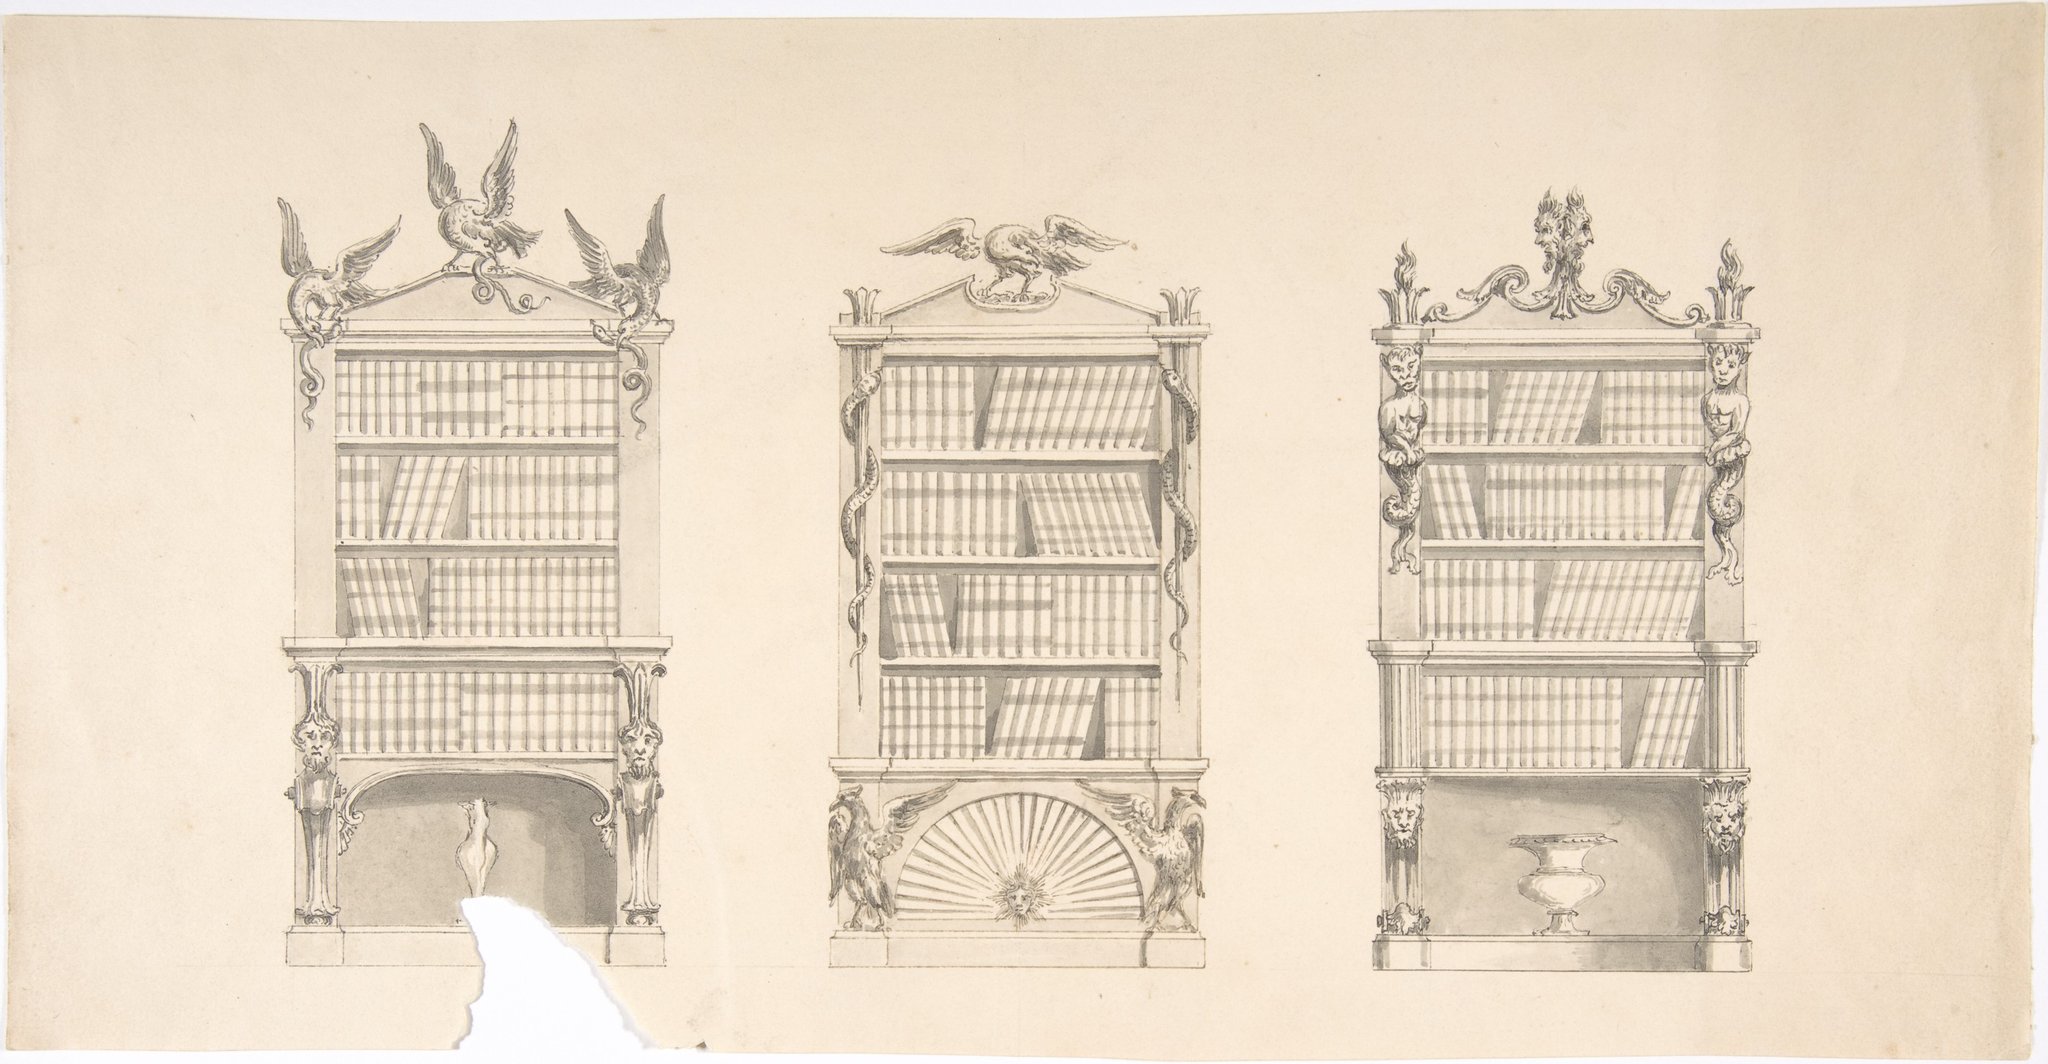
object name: drawing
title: Design for Three Bookcabinets Two Adorned with Eagles and Snakes, the other with Masks, Flames and Grotesques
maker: anonymous, british, 19th century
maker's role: artist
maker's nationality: british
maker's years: 1800-1900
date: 1801-1833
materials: graphite, ink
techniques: brush, pen, wash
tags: eagles,books,snakes,cabinets